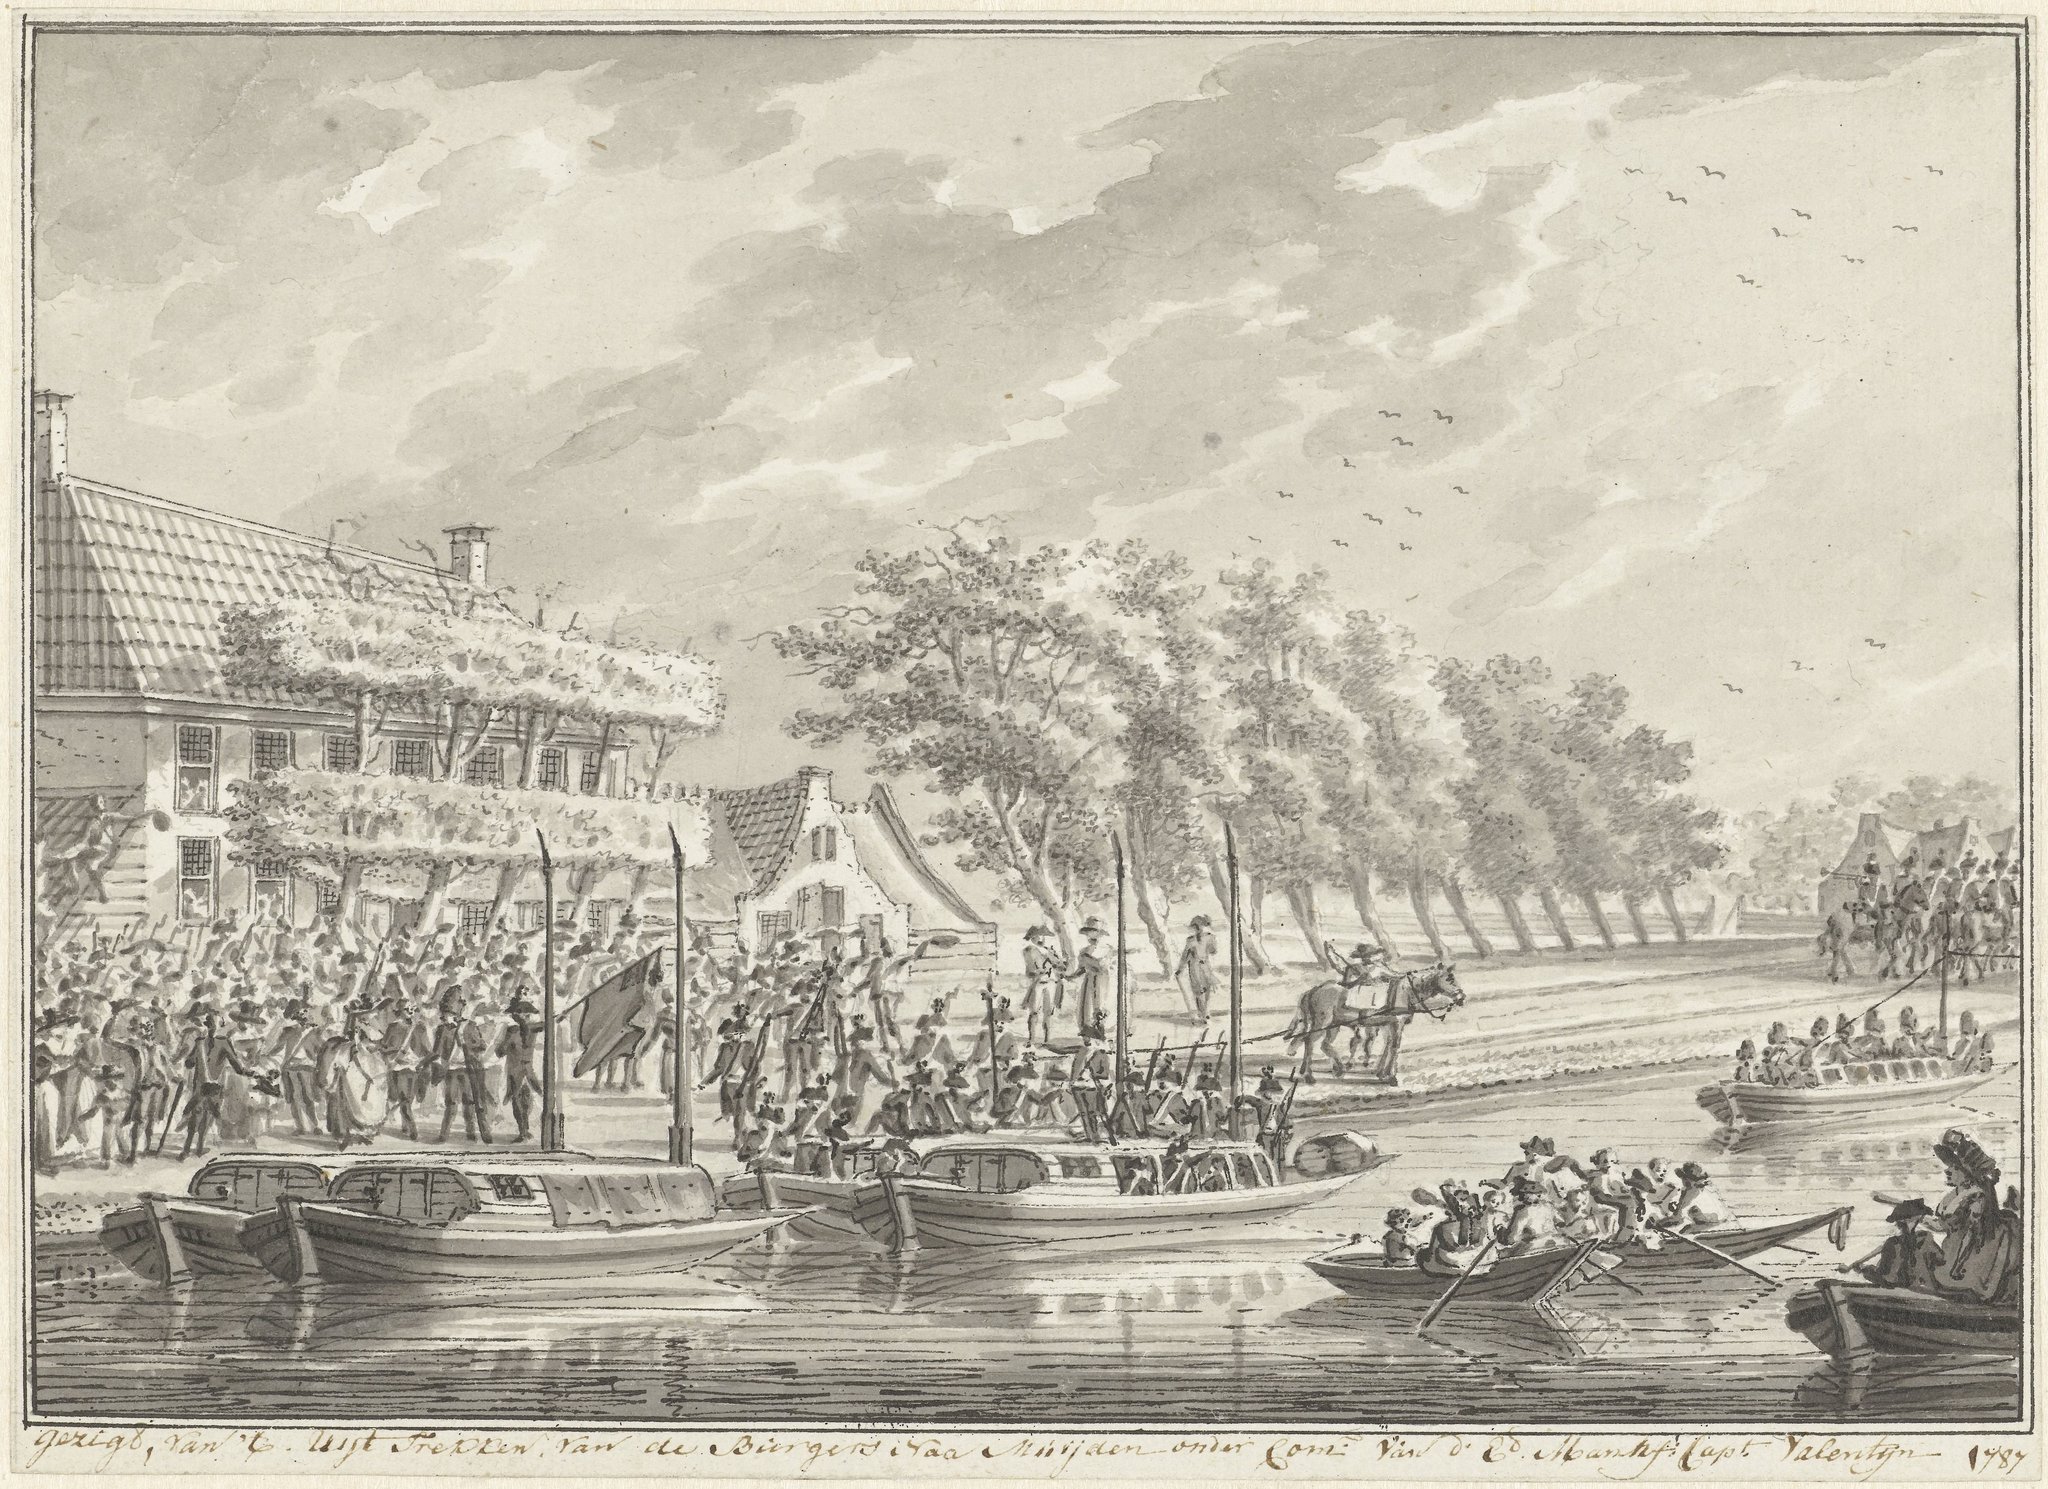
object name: drawing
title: gezigt, van 't uyt trekken van de Burgers naar Muijden onder com. van d. Ed. Manhaf. Capt. Valentyn 1787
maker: daniël kerkhoff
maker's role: draughtsman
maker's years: 1766-1821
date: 1787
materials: ink, paper, pencil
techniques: brush, pen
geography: netherlands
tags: amsterdam, patriots (1780-1795)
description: Vertrek van de gewapende Amsterdamse burgers vanuit de uitspanning Lokhorst aan de Weesperzijde in schuiten naar Muiden, 7 juni 1787.